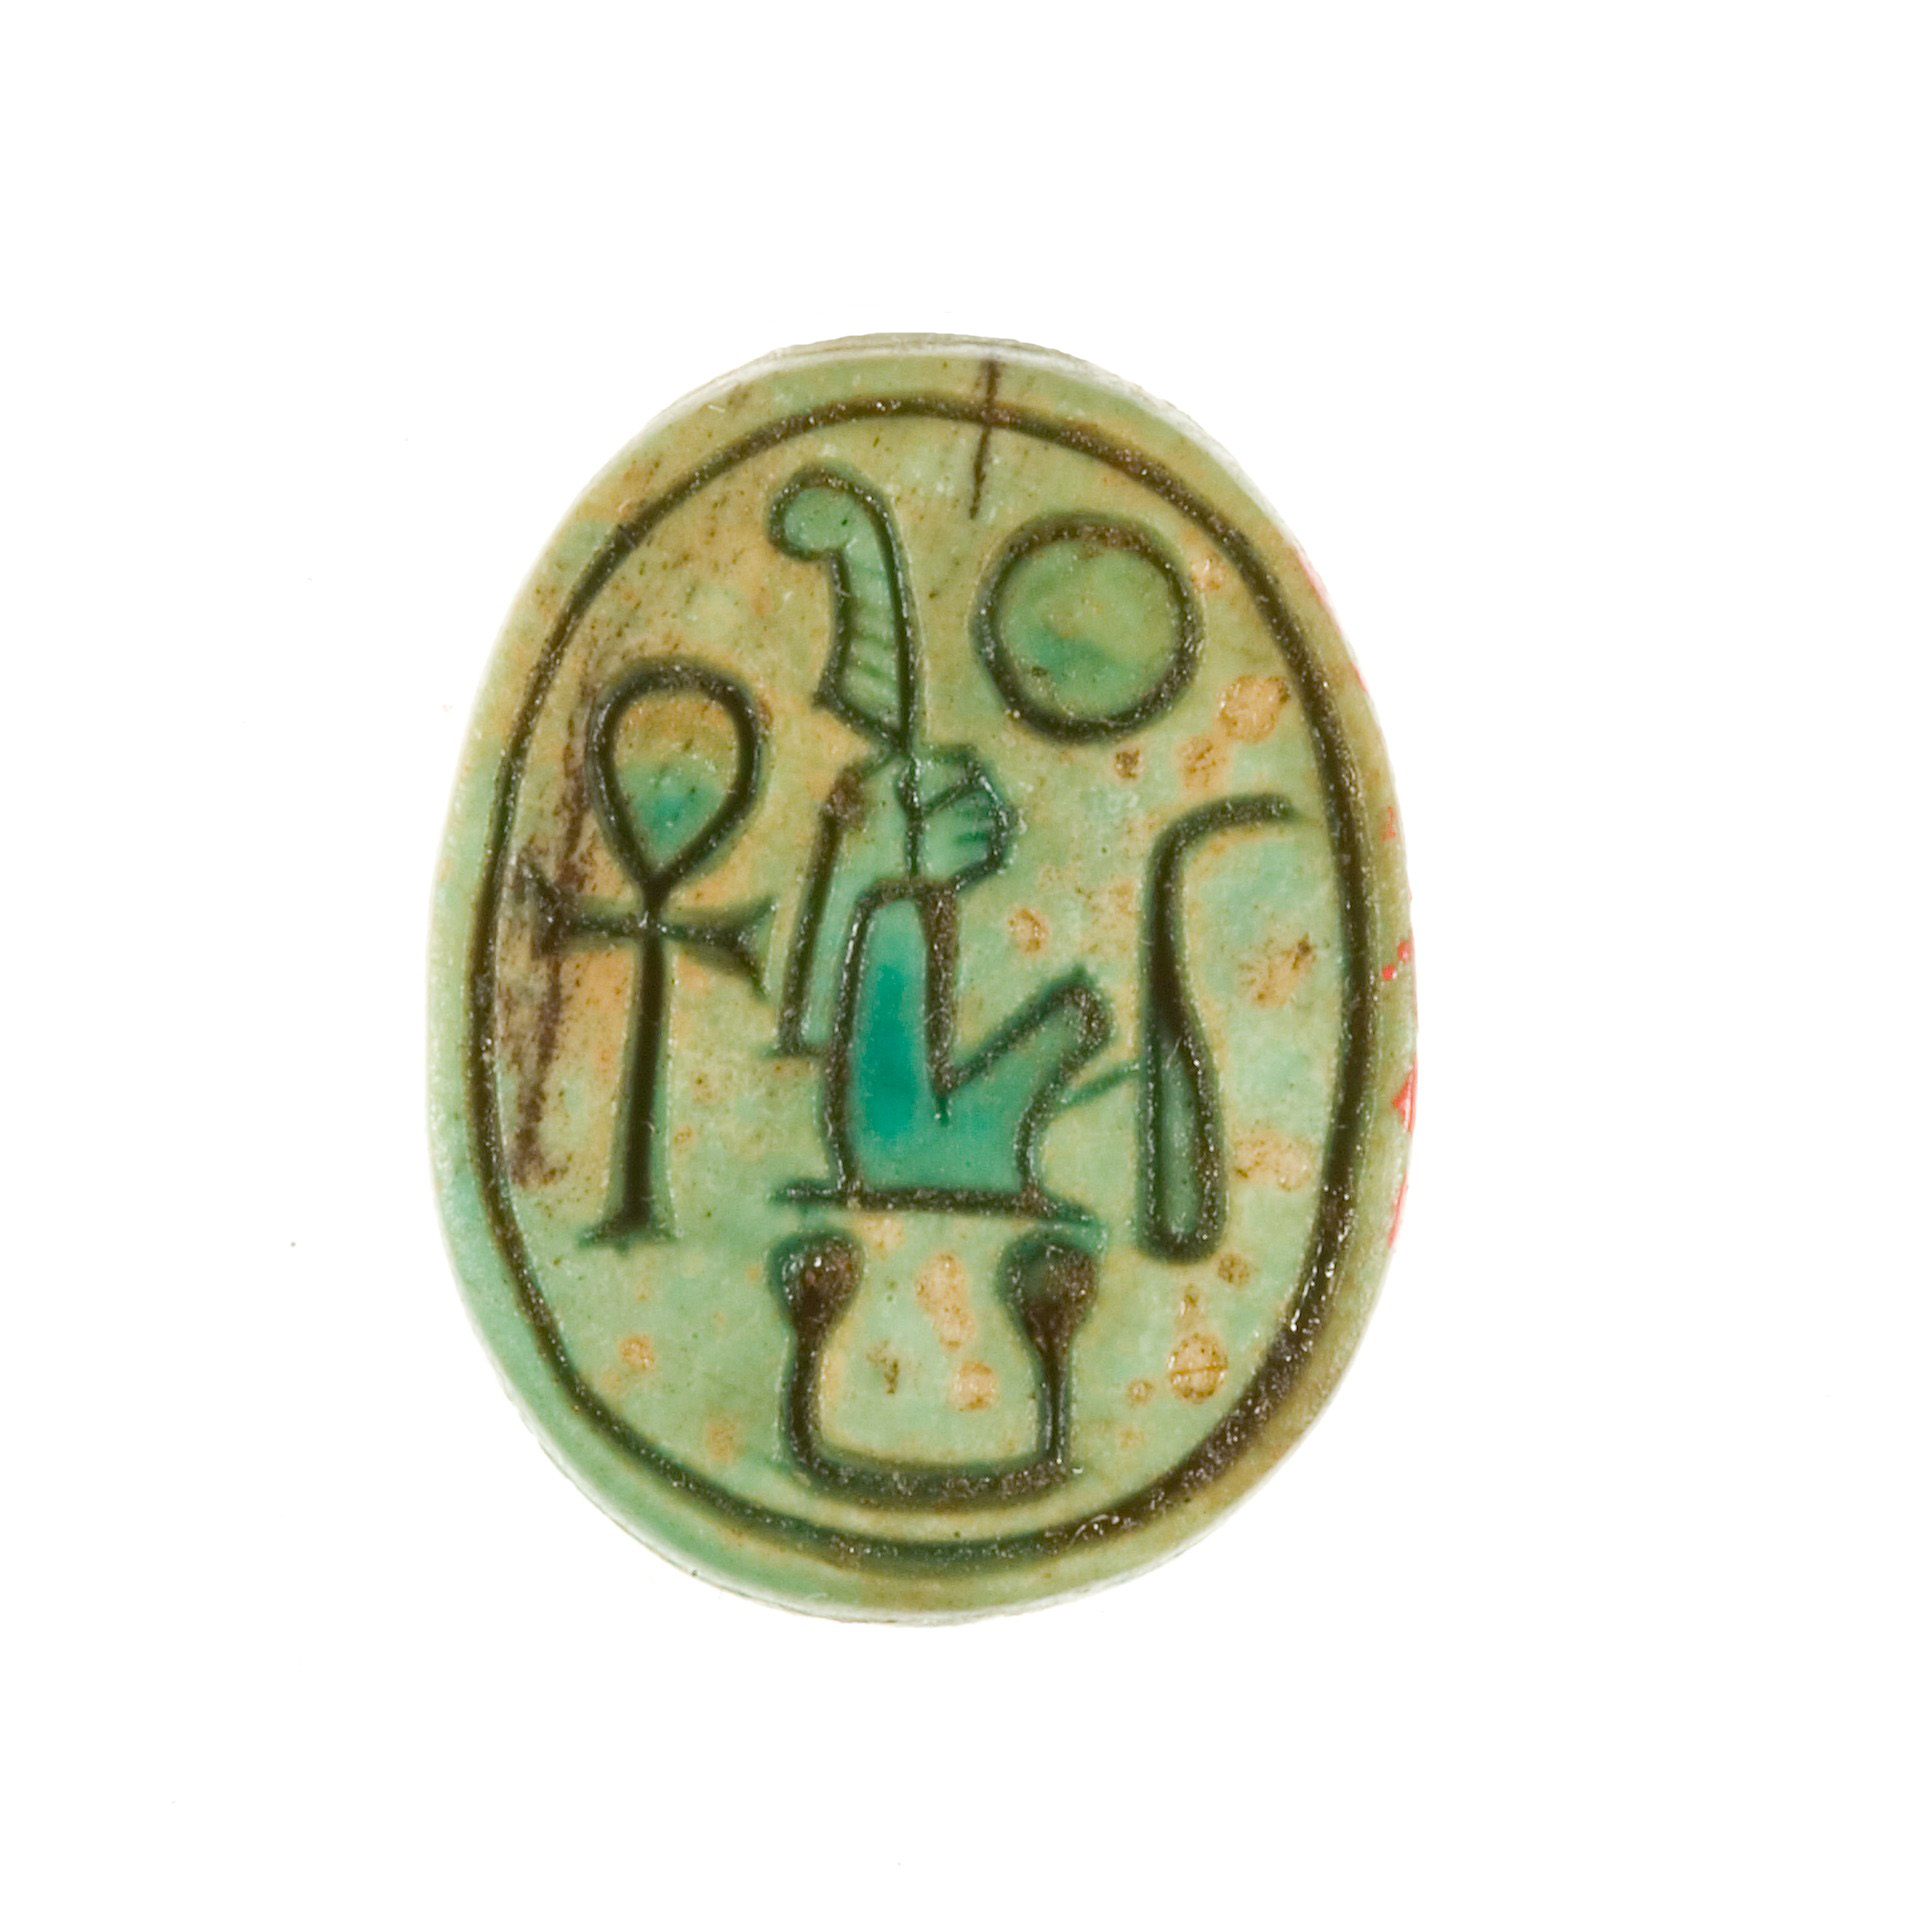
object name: scarab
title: Scarab Inscribed Maatkare (Hatshepsut) Living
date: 1479-1458 BCE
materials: stone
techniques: glazing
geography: egypt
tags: hieroglyphs,scarabs